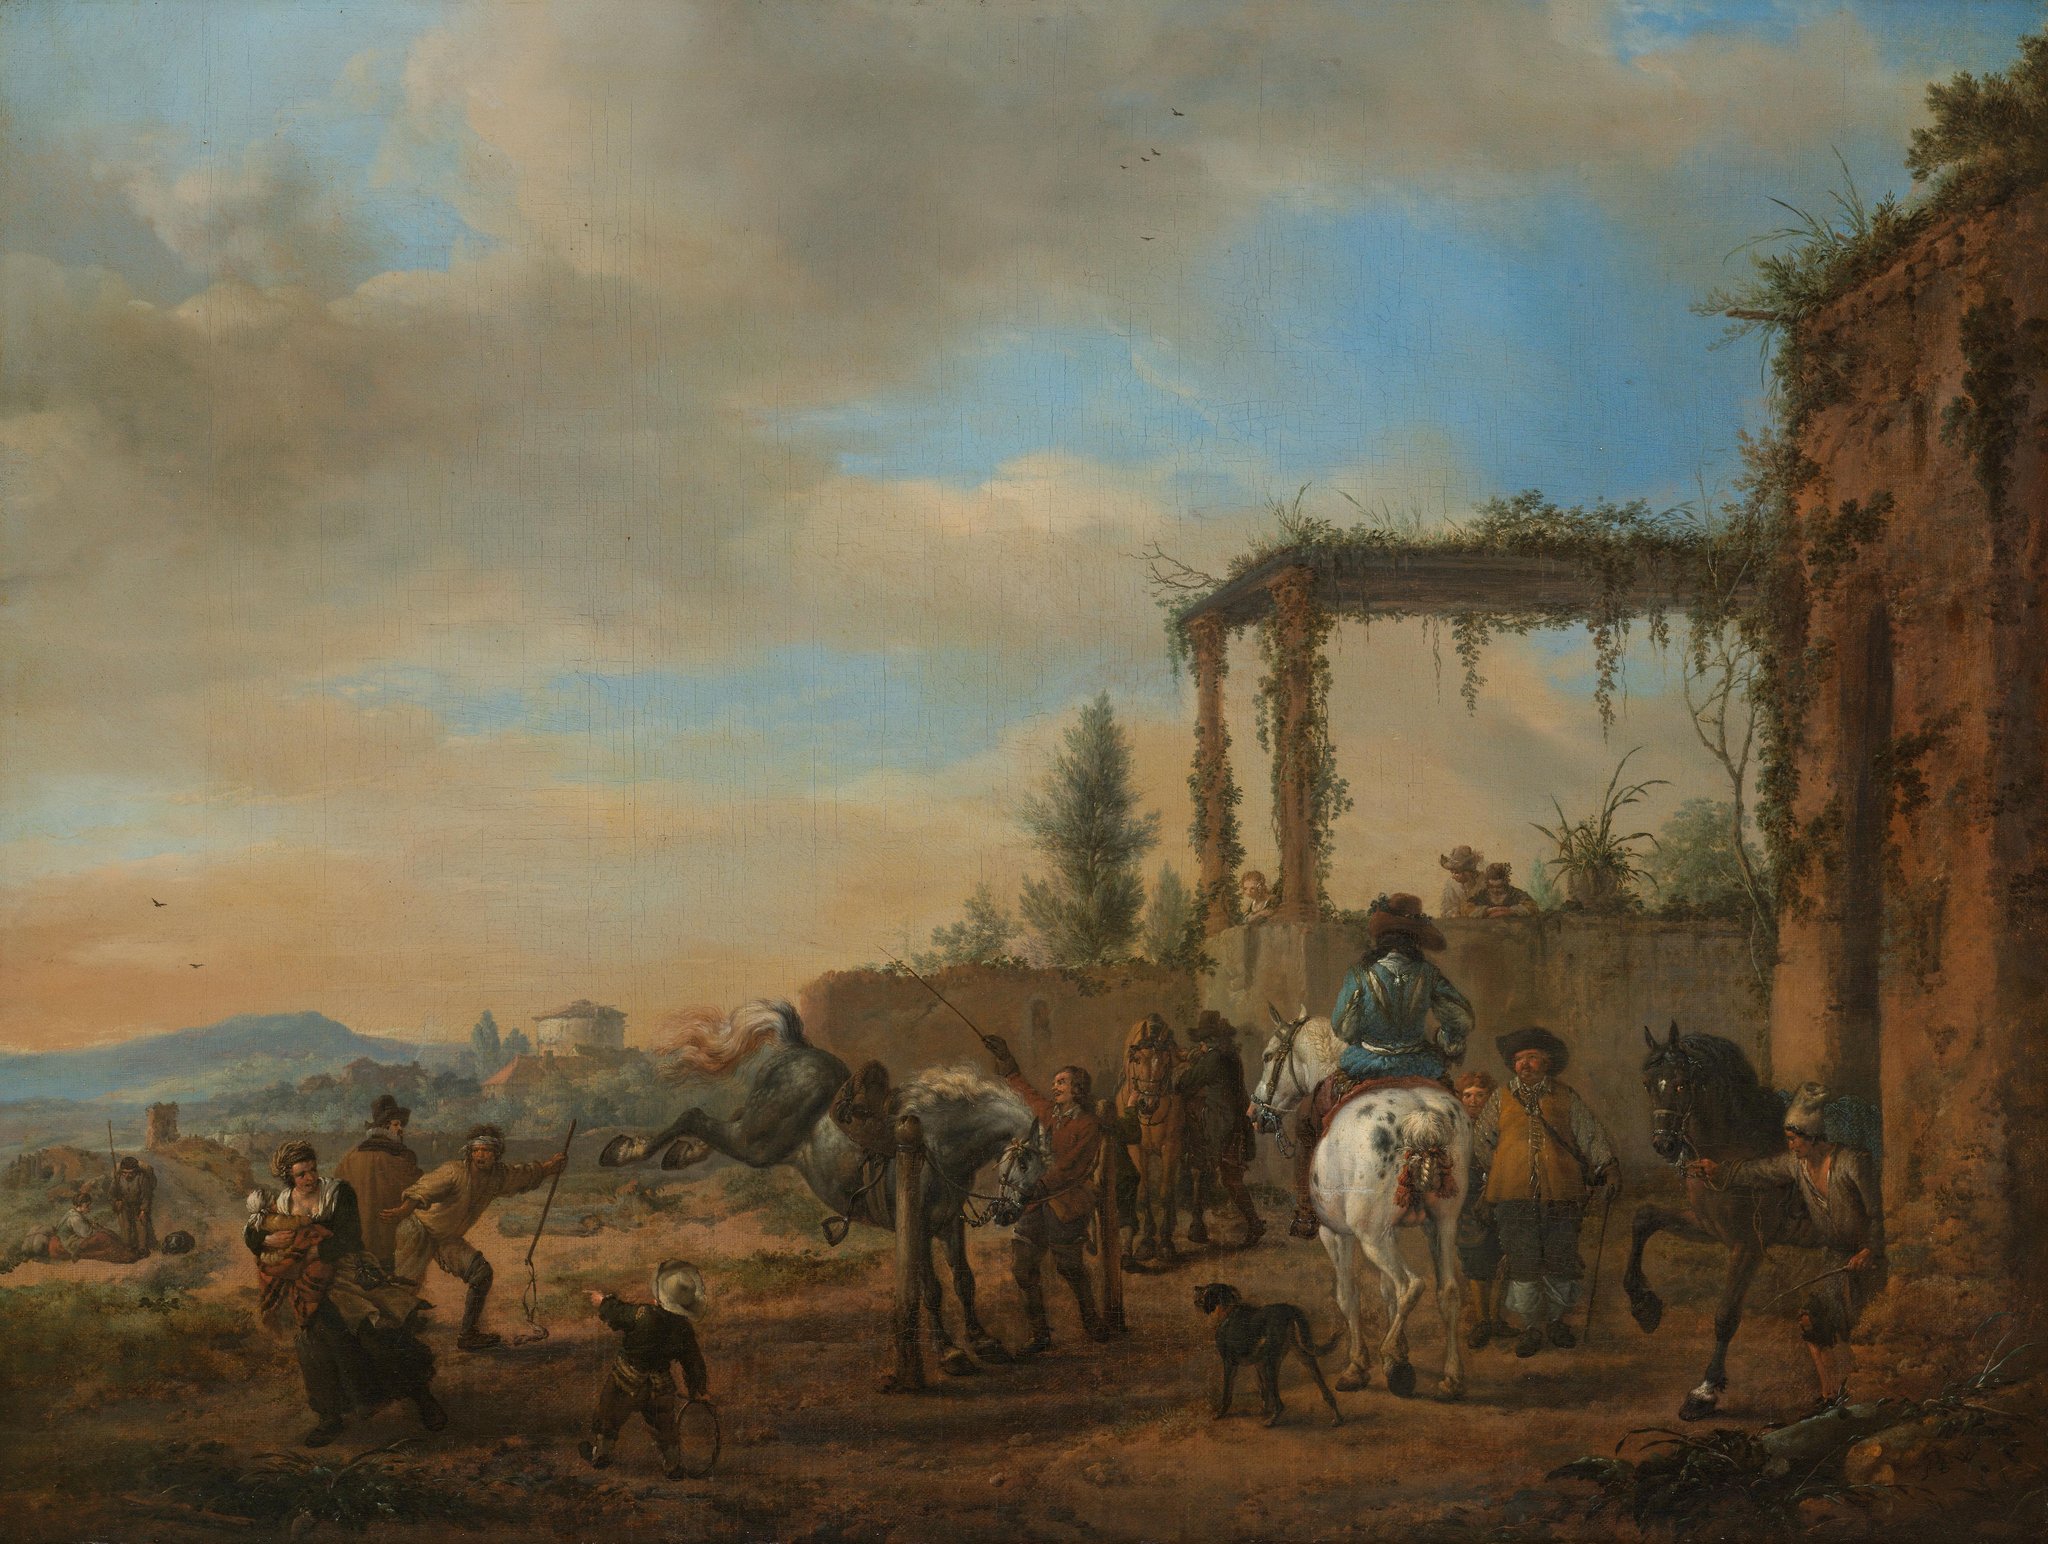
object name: painting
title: The Riding School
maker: philips wouwerman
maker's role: draughtsman, painter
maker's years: 1619-1668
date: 1658-1660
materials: canvas, oil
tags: landscape with ruins, riding-school, manège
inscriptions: signature, with monogram, lower right (letters of first name ligated): ‘PHils W’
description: Wouwerman is known for his paintings of army camps, cavalry battles and hunting scenes, in which deftly painted horses always play an important role. Thanks to his eye for detail, these paintings are very lively and anecdotal. In this painting, too, emphasis lies on narrative detail: some horses are being saddled, while a woman and child just manage to avoid being kicked by one of the animals.